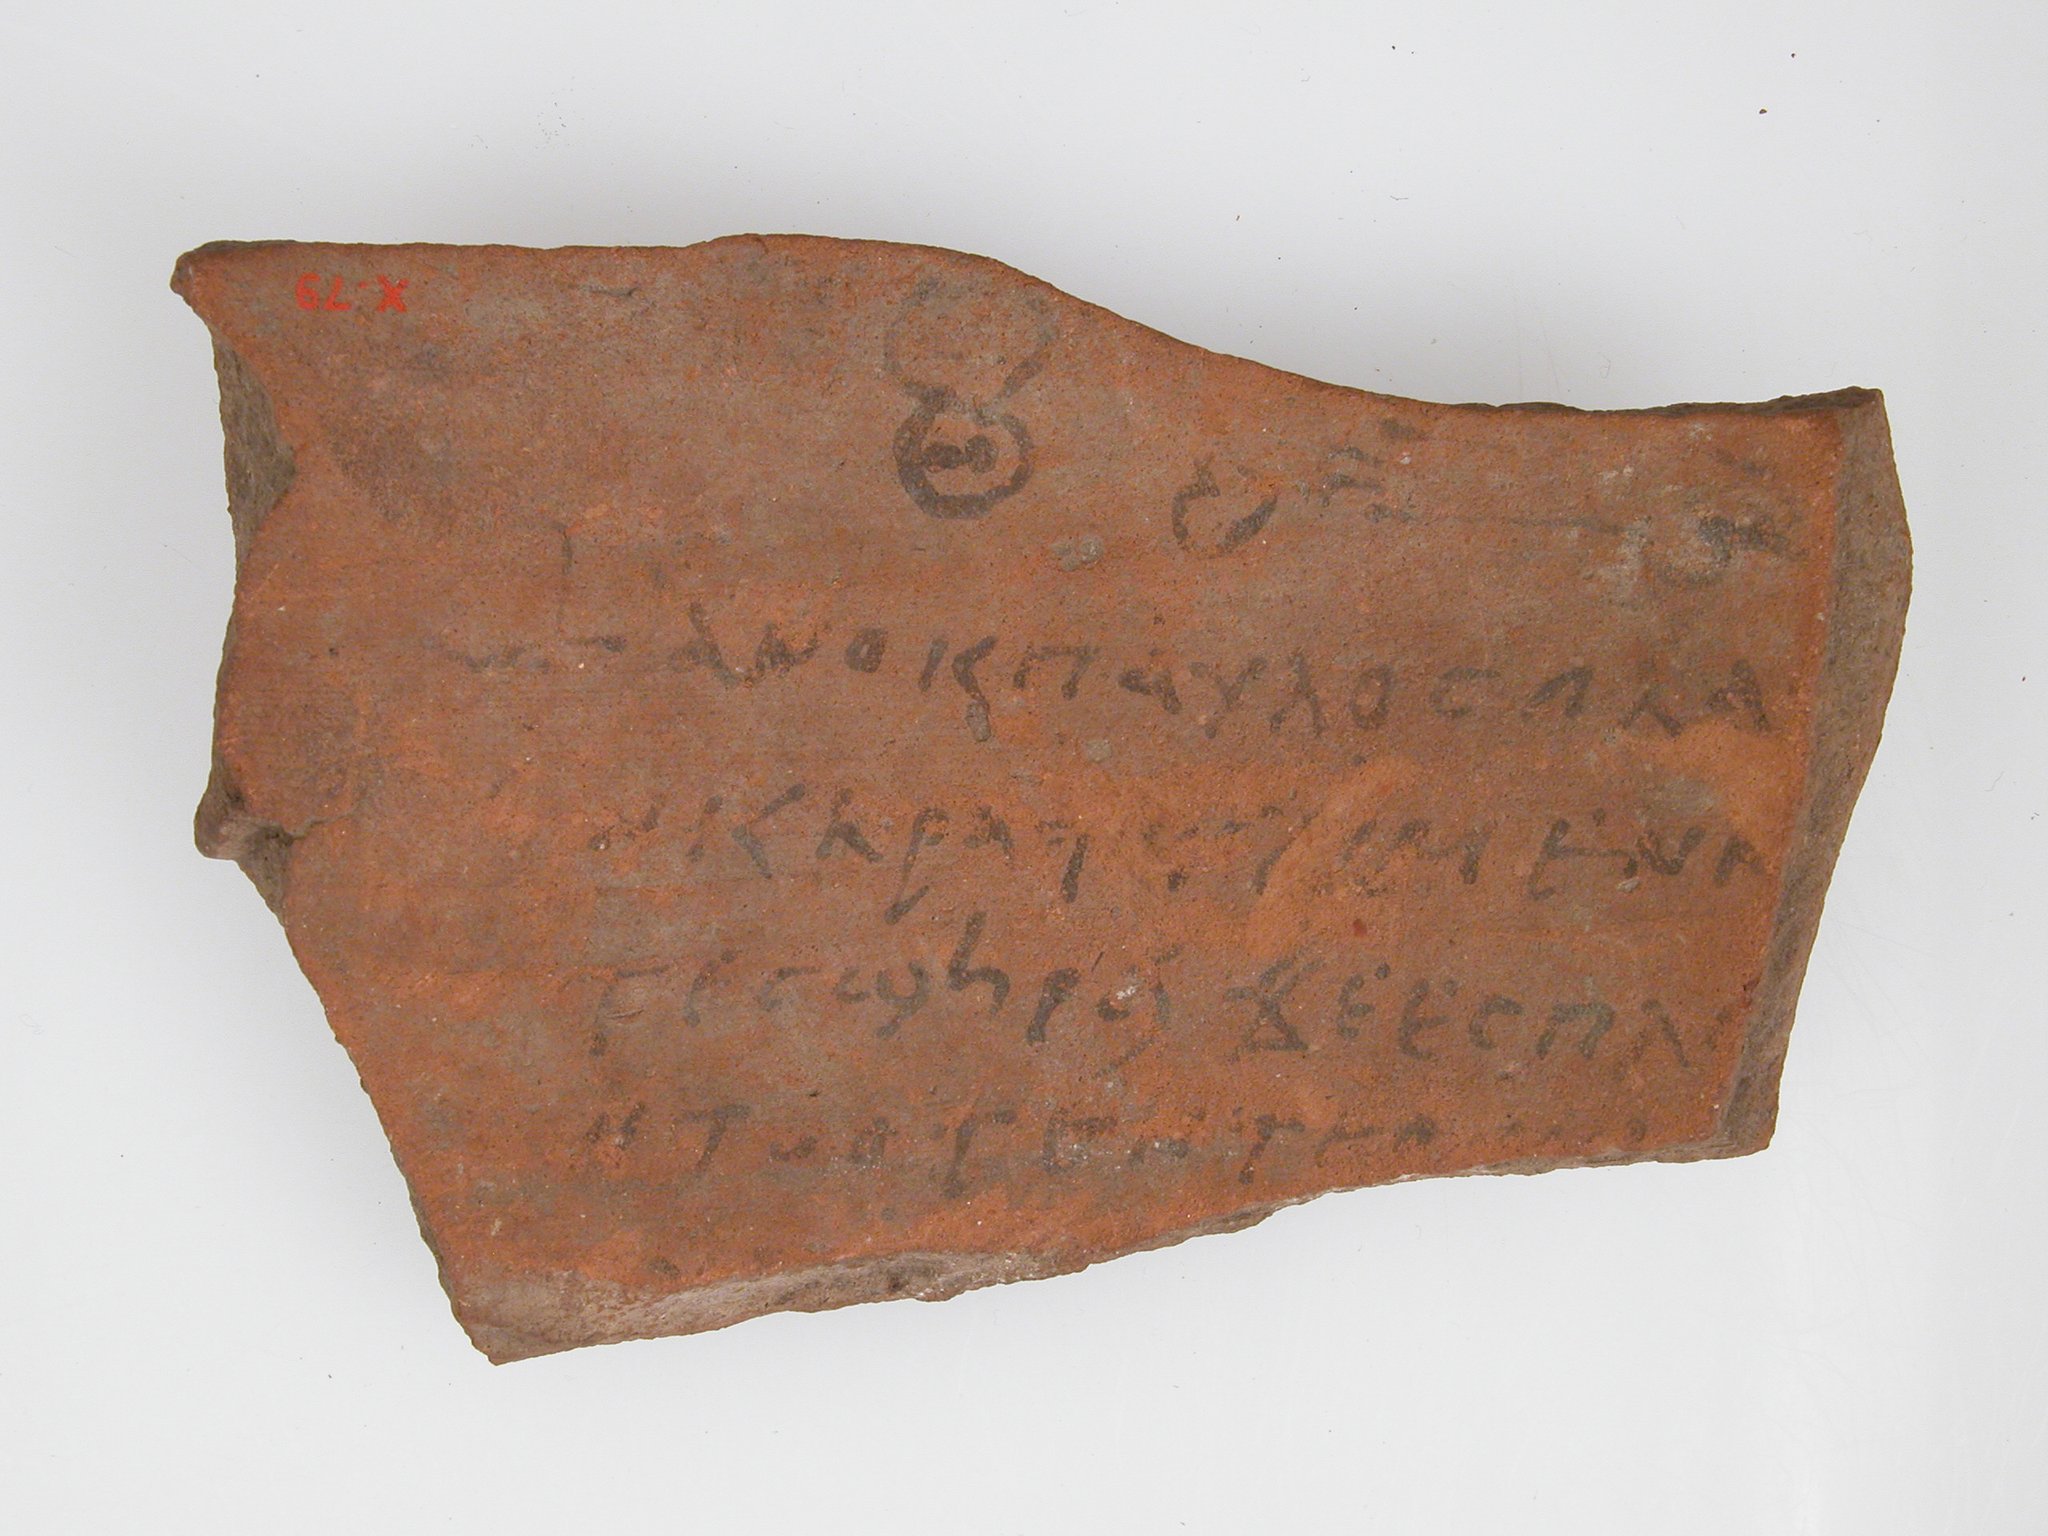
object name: ostrakon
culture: coptic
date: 301-700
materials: ink, pottery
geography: egypt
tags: documents